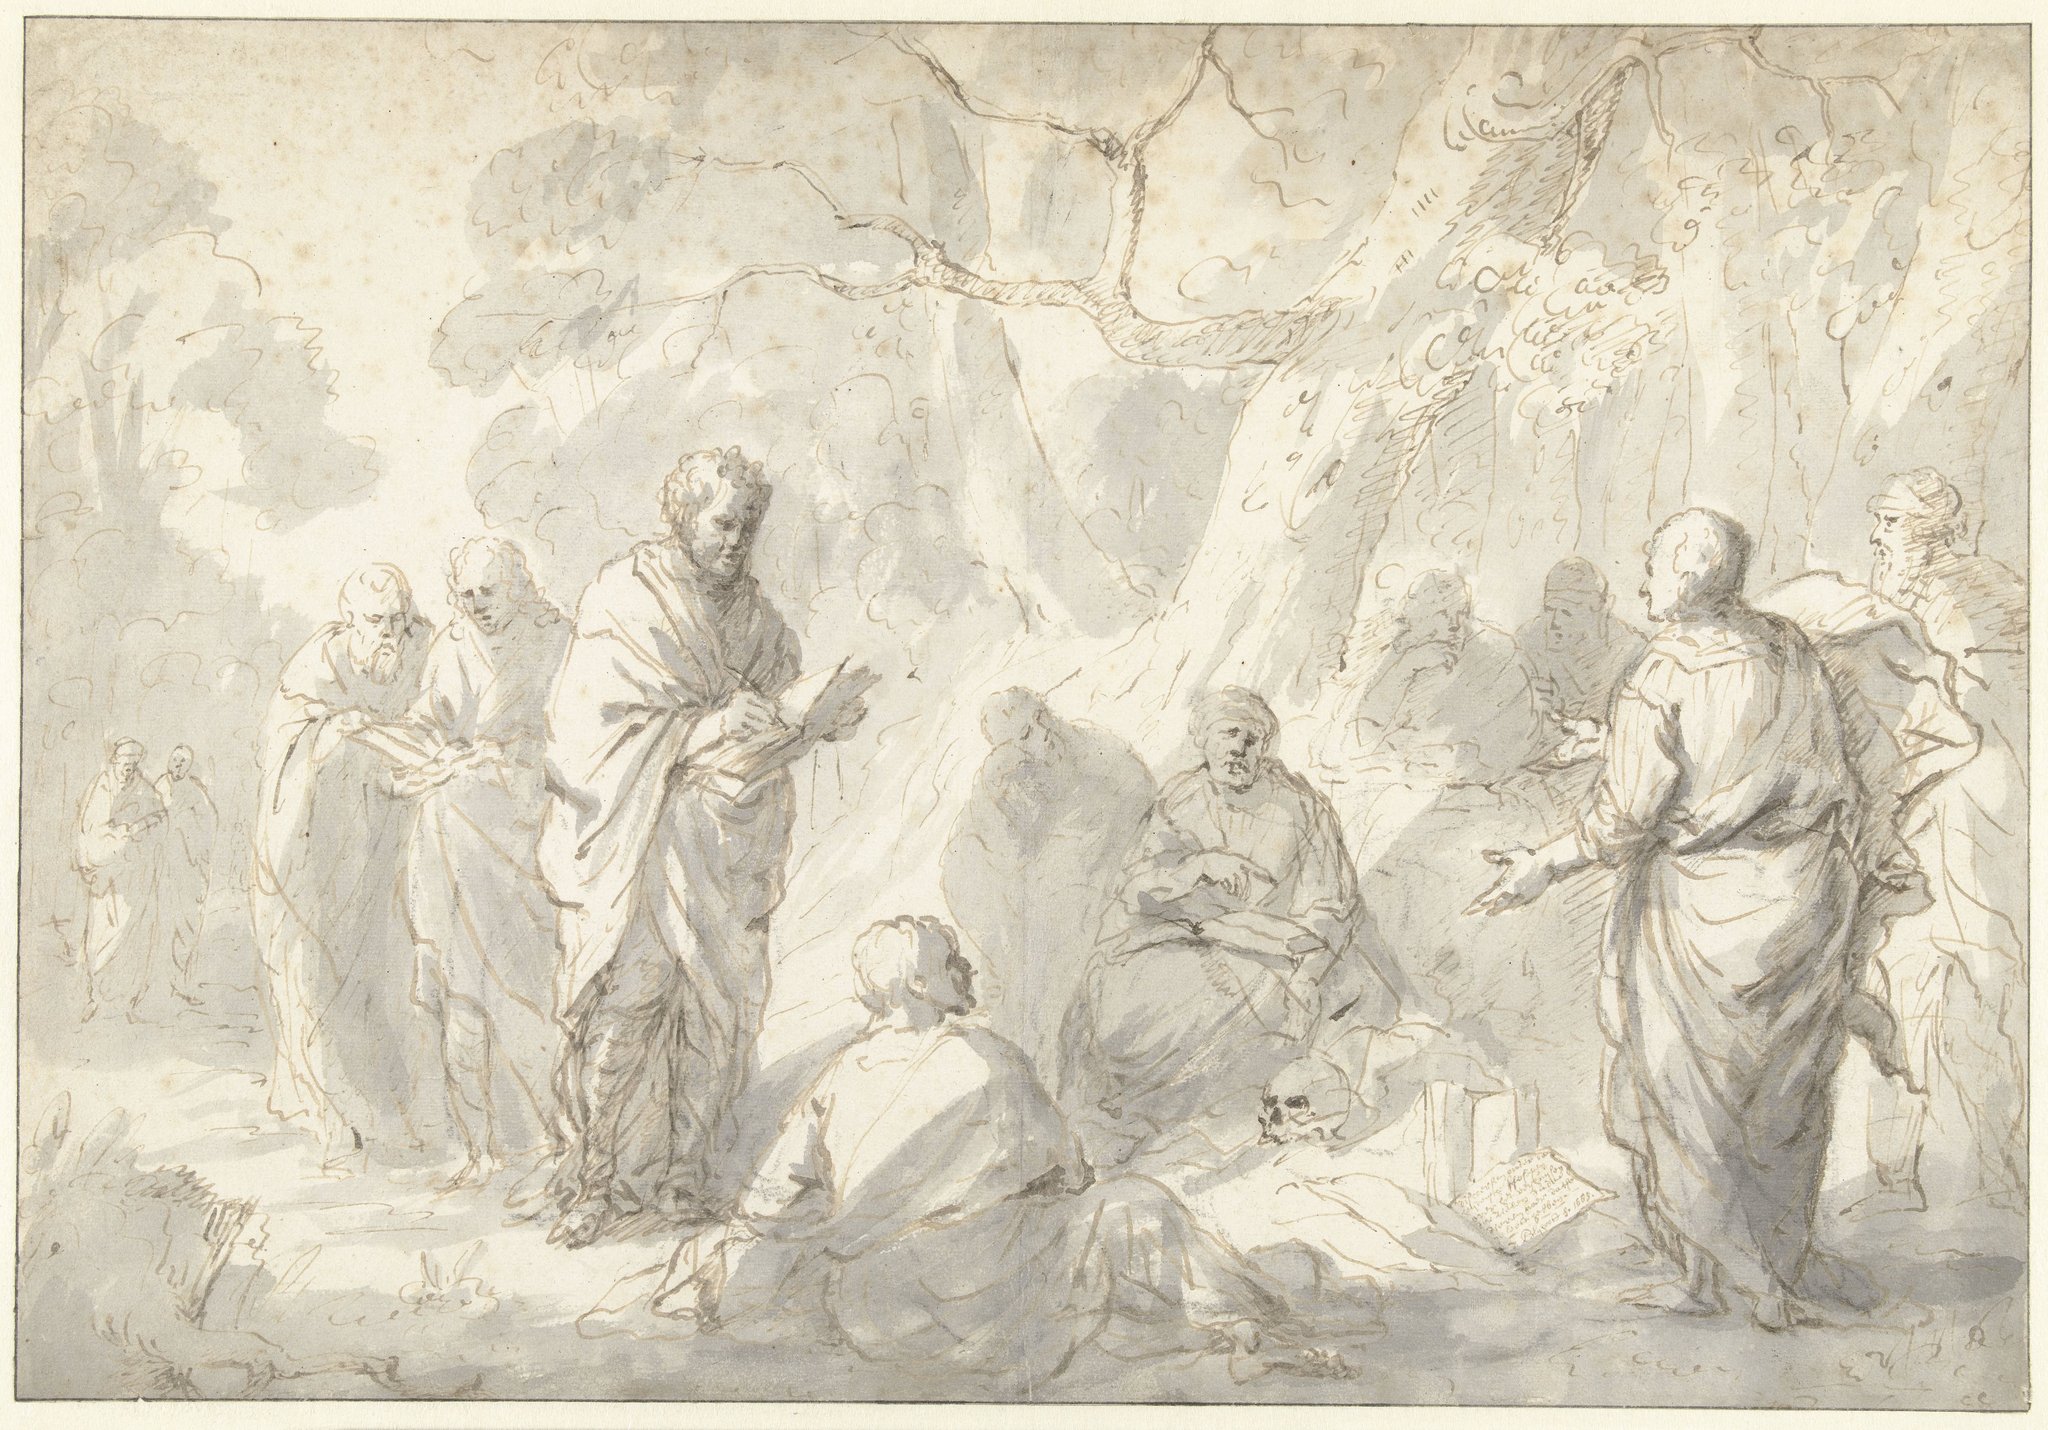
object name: drawing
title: Filosofen redetwistend over de zielsverhuizing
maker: zacharias blijhooft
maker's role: draughtsman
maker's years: 1630-1682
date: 1669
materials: chalk, graphite, ink, paper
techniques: brush, pen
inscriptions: date: ‘1669’